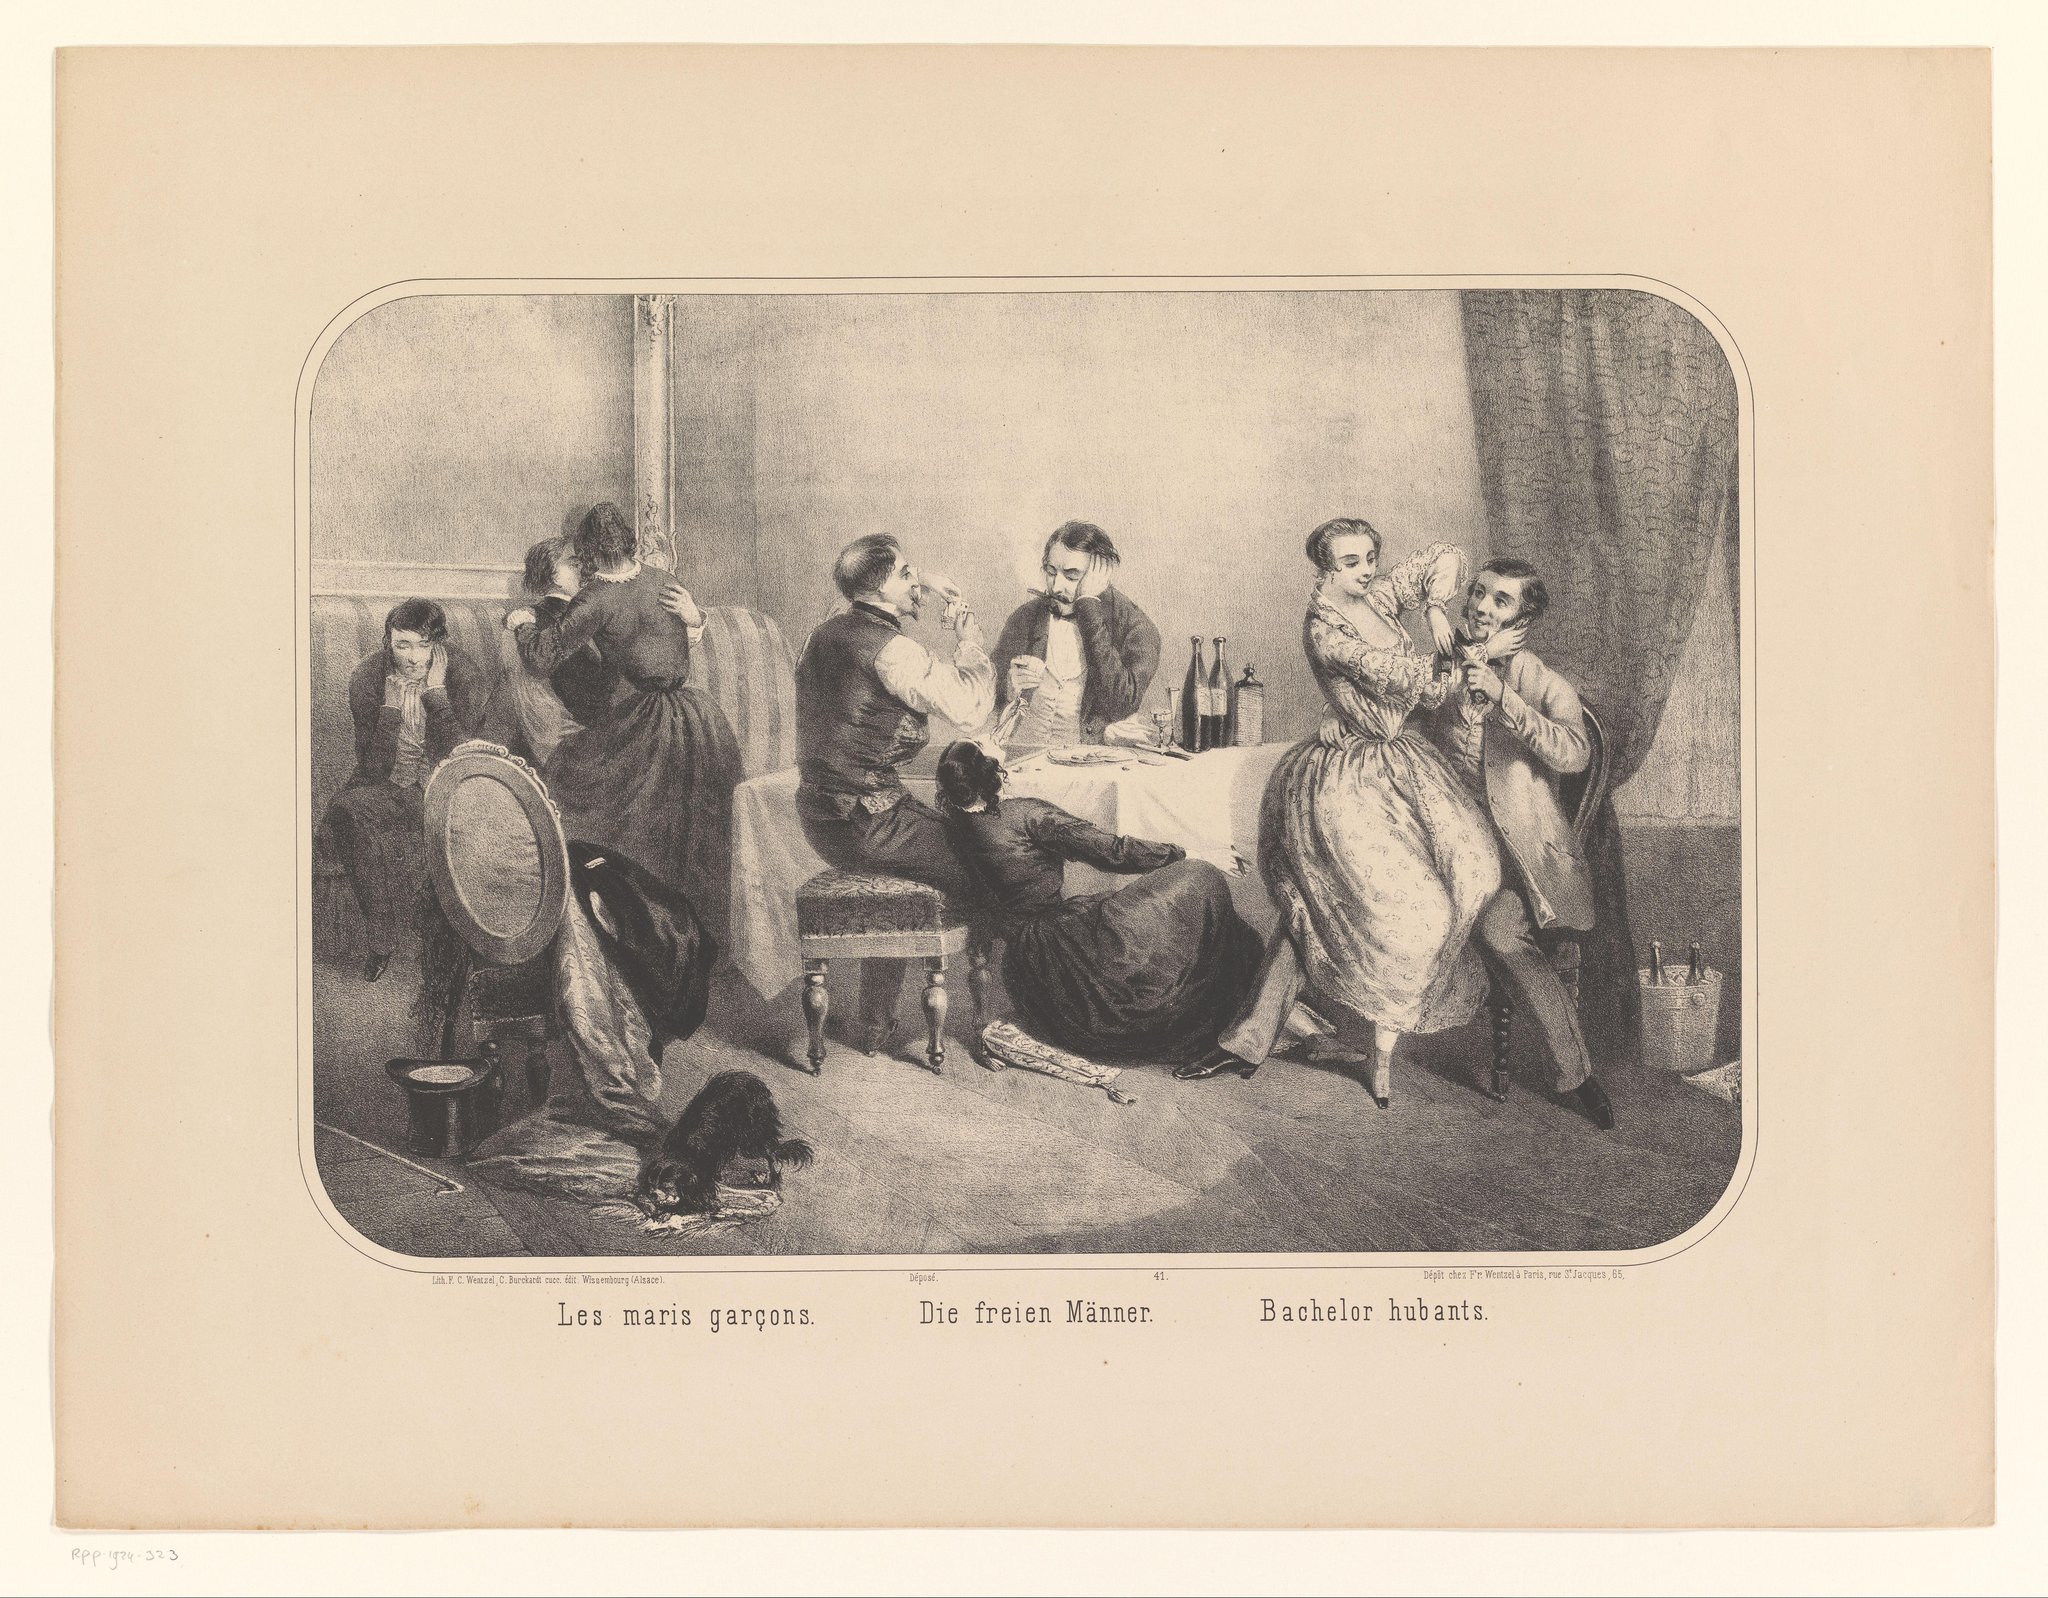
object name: print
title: Les maris garçons / Die freien Männer / Bachelor hubants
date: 1870-1899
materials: paper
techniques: lithograph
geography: wissembourg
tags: single man, bachelor, interior of the house, lovers; courting, flirting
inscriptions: collector's mark: Lugt 2233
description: Prent maakt waarschijnlijk deel uit van een serie met genrevoorstellingen. Over deze serie is verder niets bekend. Het betreft voornamelijk voorstellingen van mannen die vrouwen het hof maken.